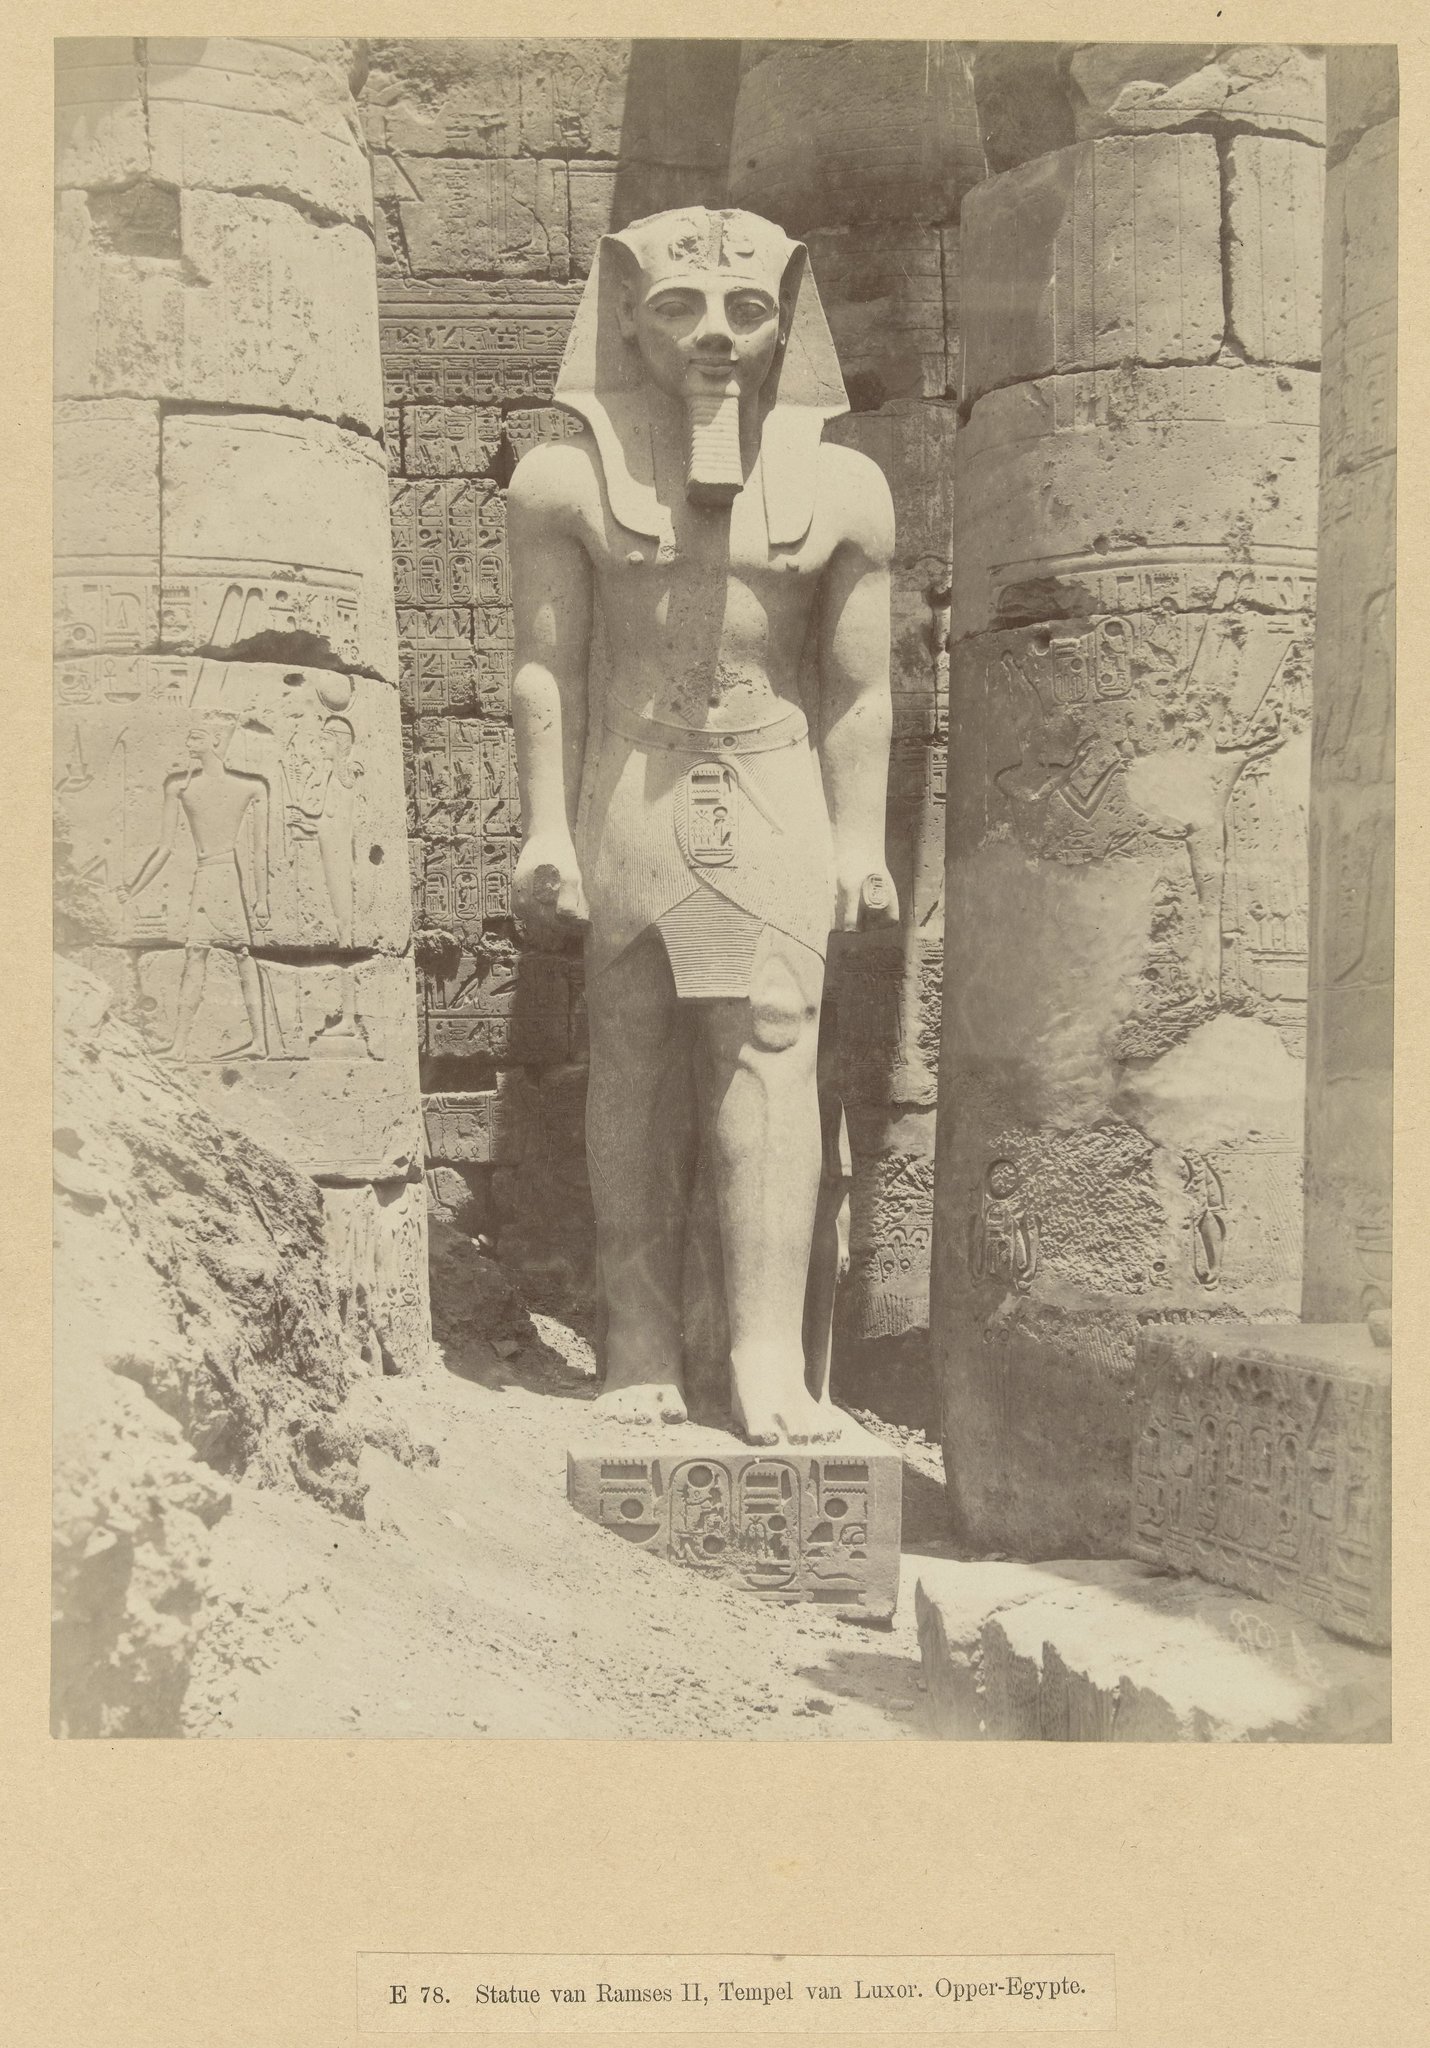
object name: photograph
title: E 78. Statue van Ramses II, Tempel van Luxor. Opper-Egypte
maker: antonio beato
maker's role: fotograaf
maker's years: 1835-1906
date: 1862-1895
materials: cardboard, paper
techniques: albumen print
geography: luxor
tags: temple, shrine ~ egyptian religion, monument, statue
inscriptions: check stamp: ‘Bristol/ L.M.’, title: ‘E 78. Statue van Ramses II, Tempel van Luxor. Opper-Egypte.’, stamp: ‘GEMEENTELIJKE BIBLIOTHEEK/ ROTTERDAM’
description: Onderdeel van een groep door fotograaf Richard Polak op reis verzamelde foto’s. Deze foto is samen met andere op zijn reizen verzamelde foto's tentoongesteld bij de Rotterdamsche Kunstkring (1895), Arti en Amicitiae te Amsterdam (1897-1898?) en Societeit 't Collegie te Kampen (datum vooralsnog onbekend).